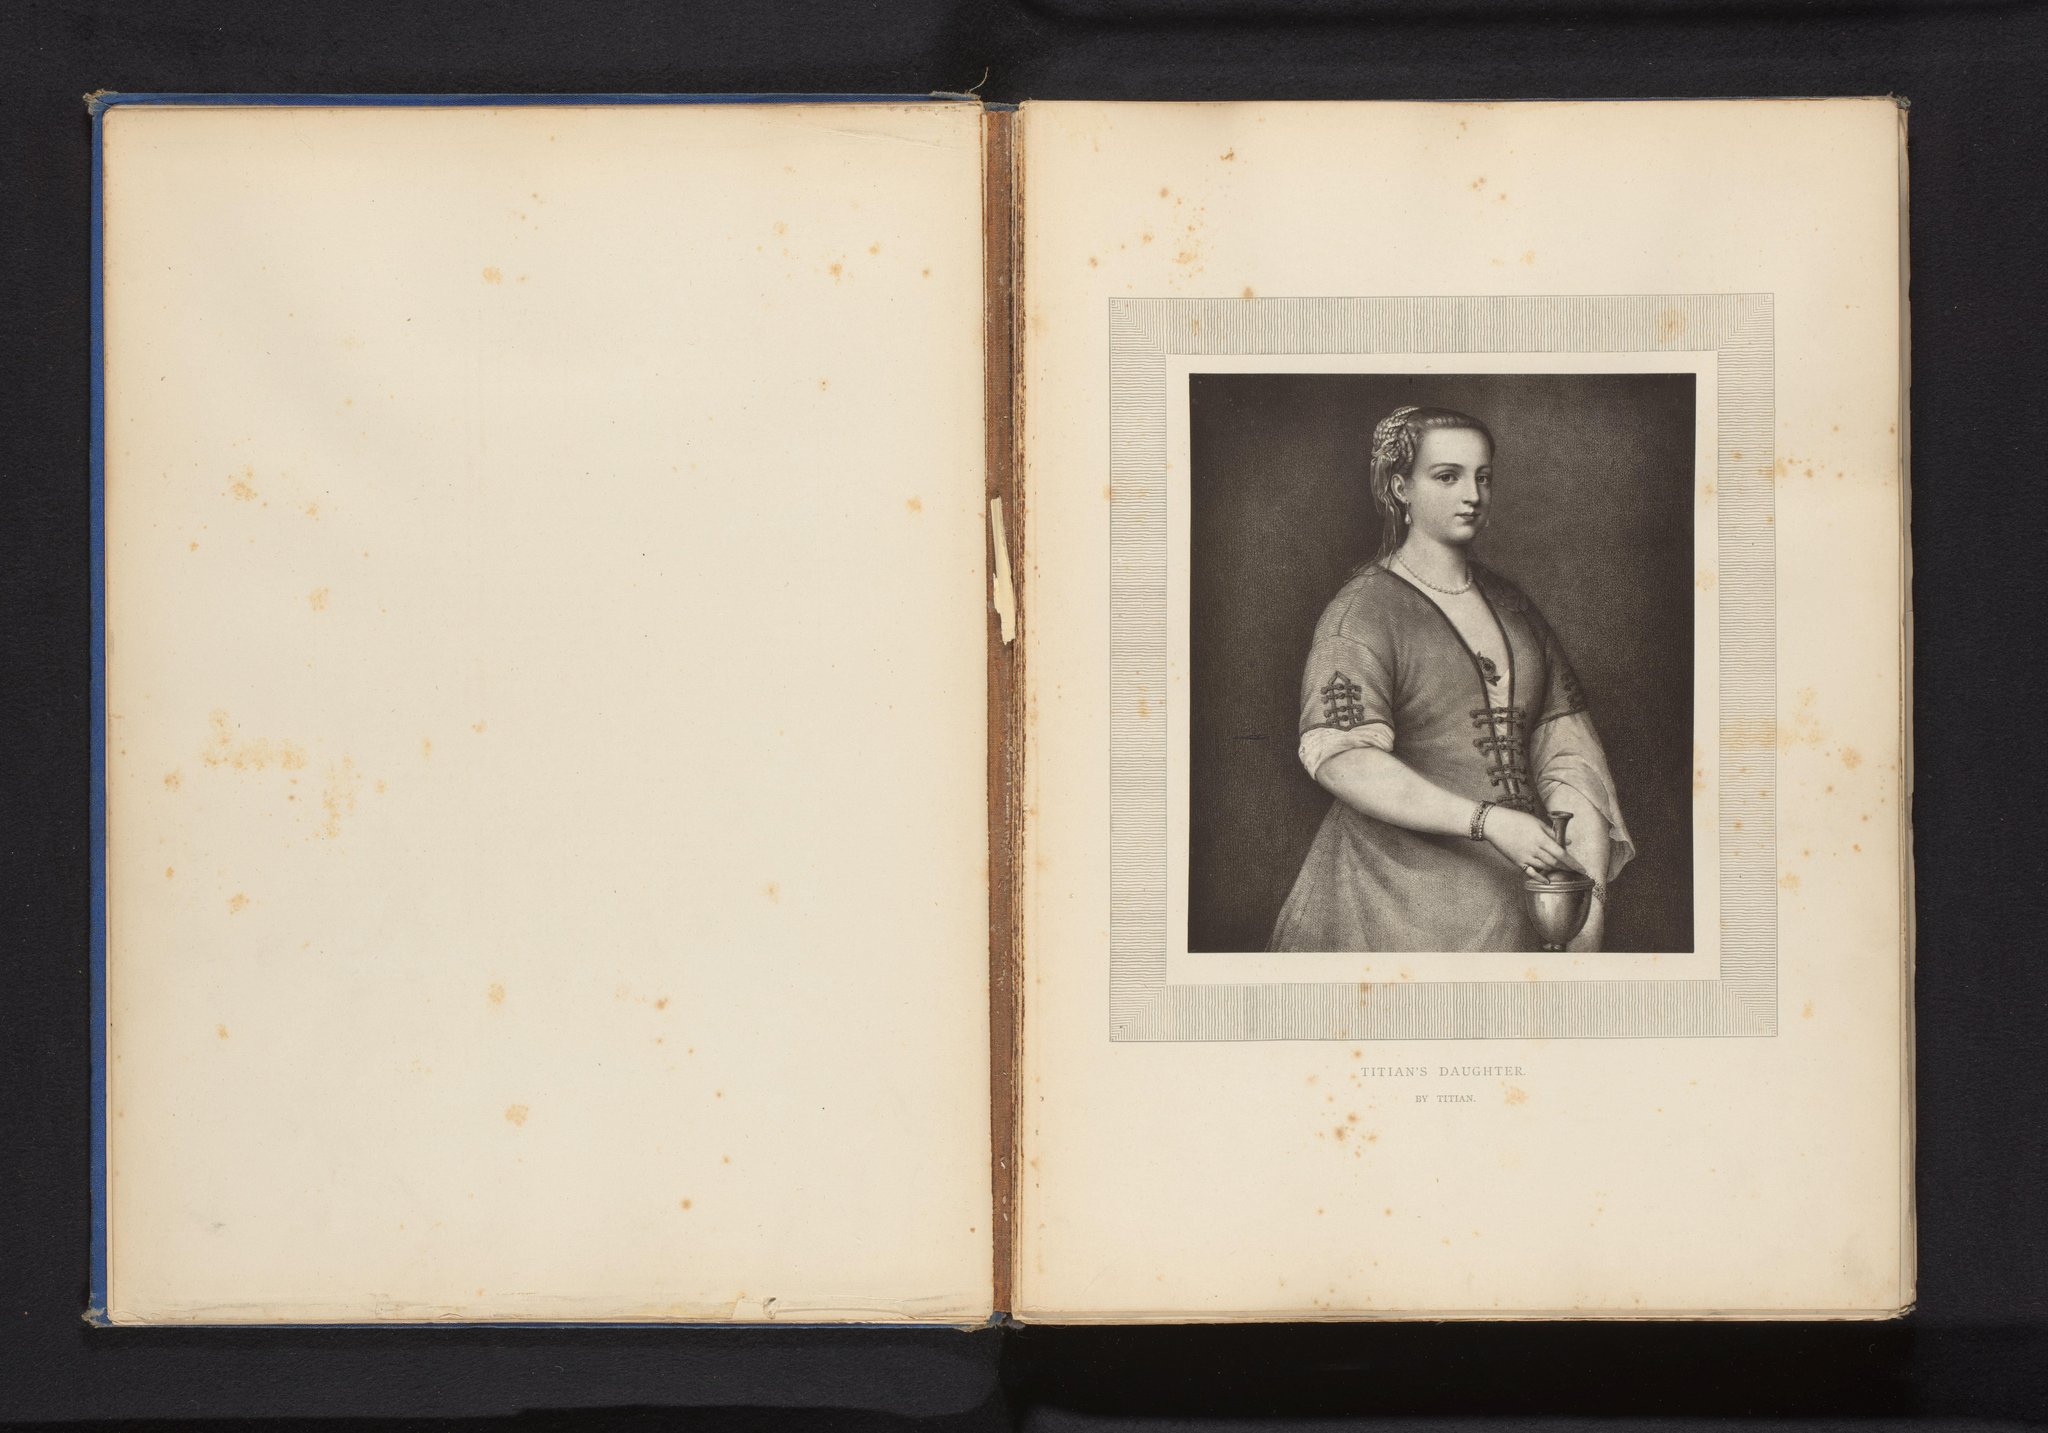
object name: photomechanical print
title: Titian's daughter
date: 1870-1875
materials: paper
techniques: woodburytype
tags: historical persons - bb - woman